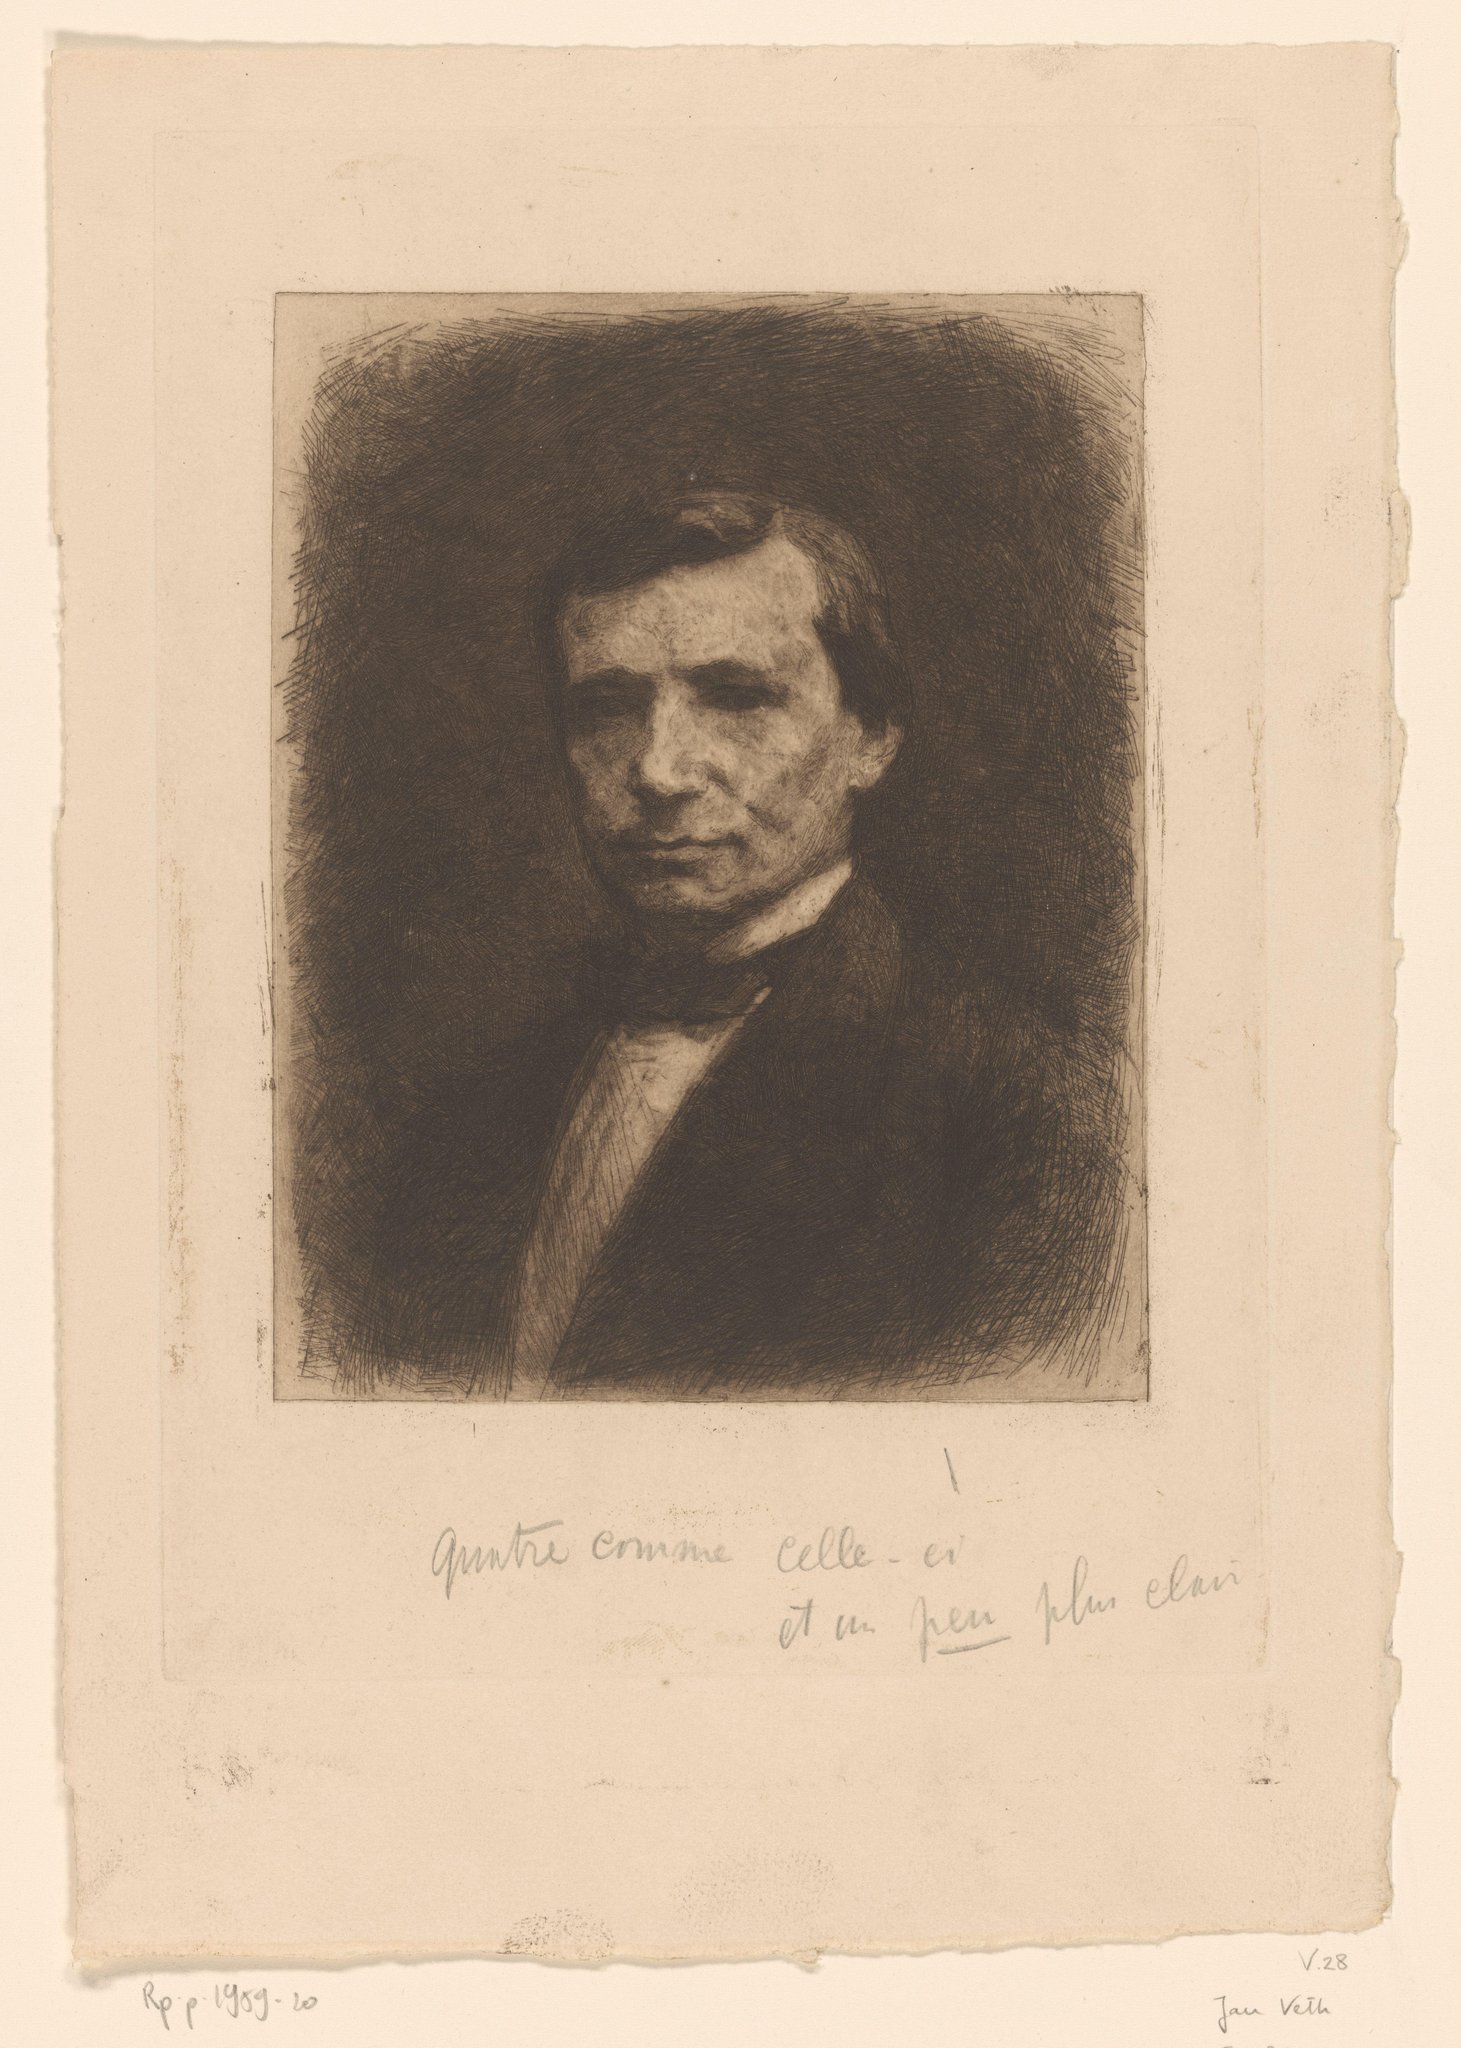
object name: print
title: Portret van Anders Celsius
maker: johann gottlieb boettger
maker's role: print maker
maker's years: 1763-1825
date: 1794-1825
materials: paper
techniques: stippling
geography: leipzig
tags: historical persons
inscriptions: collector's mark: Lugt 2228